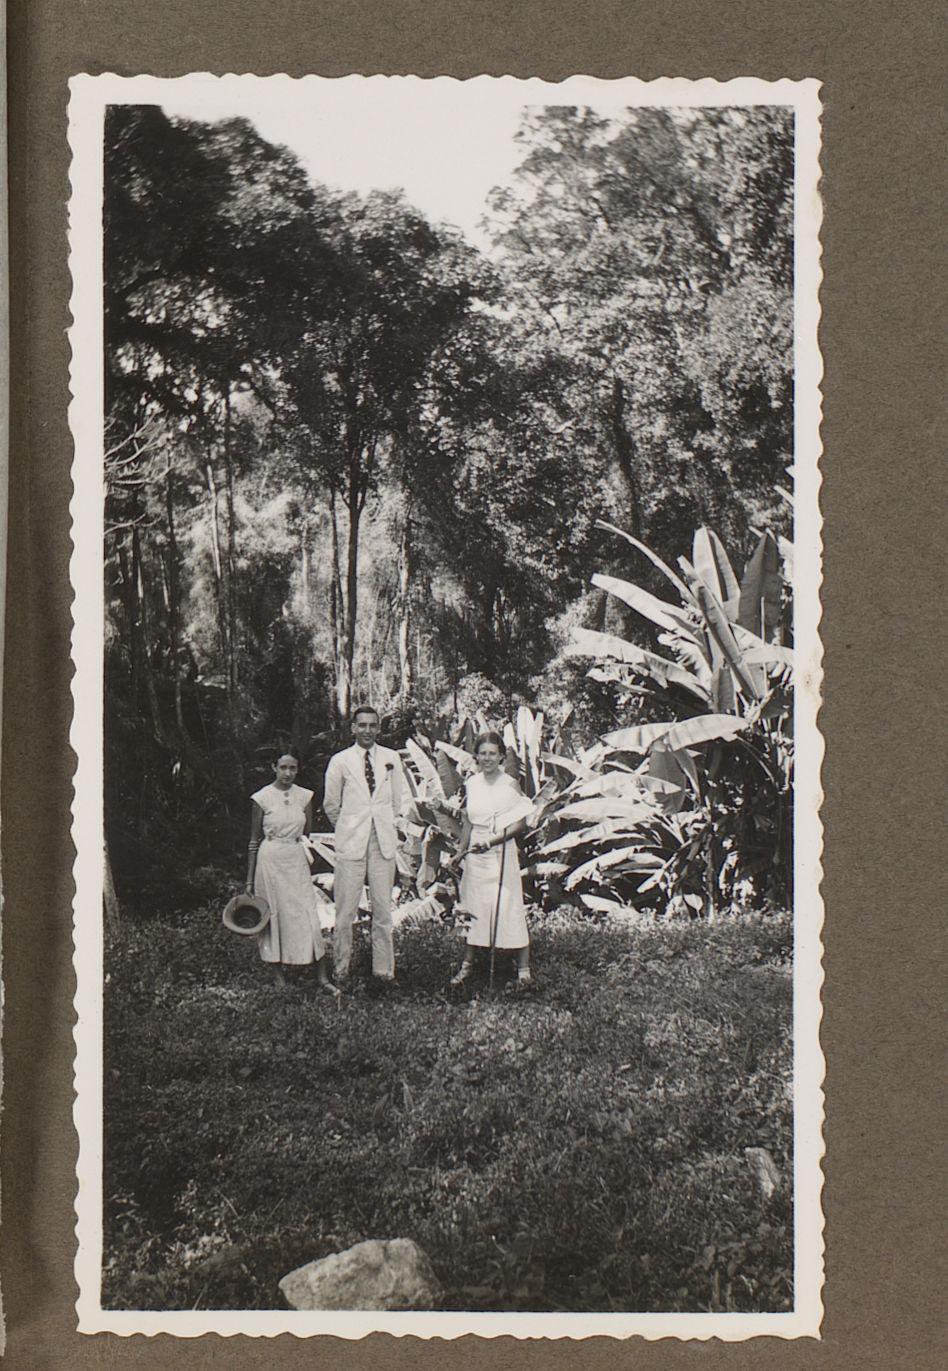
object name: album leaf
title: Gezelschap met Dootje van Zijll de Jong in het bos, nabij Bandoeng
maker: Anonymous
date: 1933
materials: paper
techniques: gelatin silver print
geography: west java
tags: amsterdam, historical persons - bb - woman, forest, wood